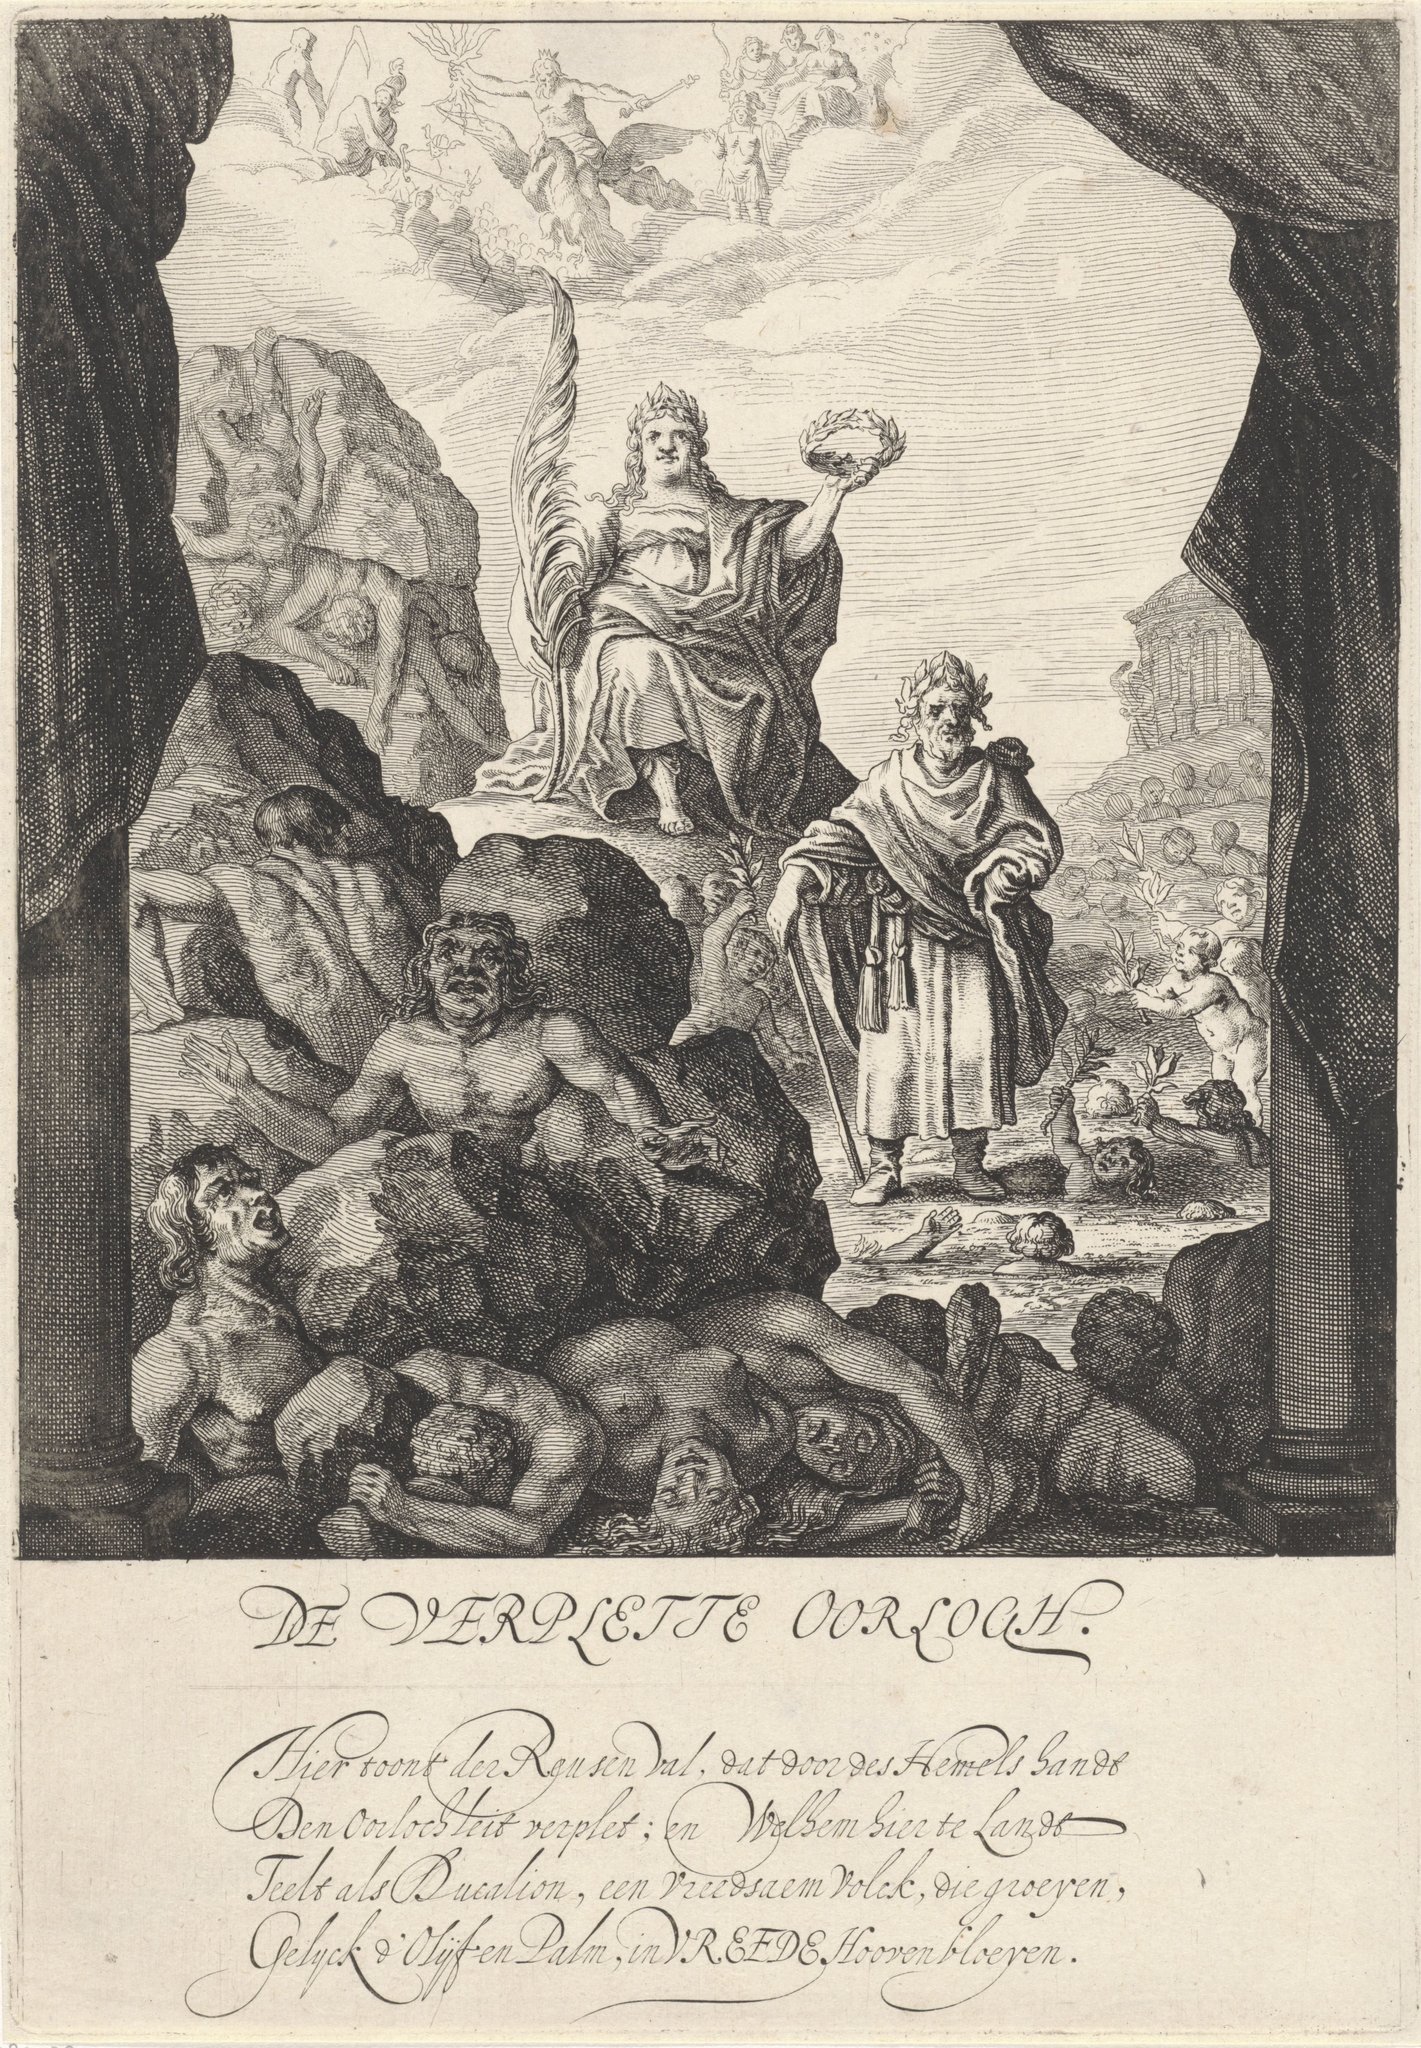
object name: print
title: Vertoning van het Verpletteren van de Oorlog, 1648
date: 1649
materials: paper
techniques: etching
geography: amsterdam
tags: symbols, allegories of peace, 'pax'; 'pace' (ripa), theatre, theatrical performance, festivities on events of national importance, stones turning into men: stones thrown by deucalion and pyrrha, as directed by the oracle of themis, turn into men (ovid, metamorphoses x 400), the giants buried beneath volcanoes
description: Vertoning van het Verpletteren van de Oorlog. Onderdeel van de vertoningen opgevoerd op 23 juni 1648 op de Schouwburg te Amsterdam naar aanleiding van het sluiten van de Vrede van Munster. De vijfde voorstelling toont hoe de Oorlog onder een stapel rotsblokken wordt verpletterd. Deucalion en Vrede zien toe. In het onderschrift een vers van 4 regels in het Nederlands.